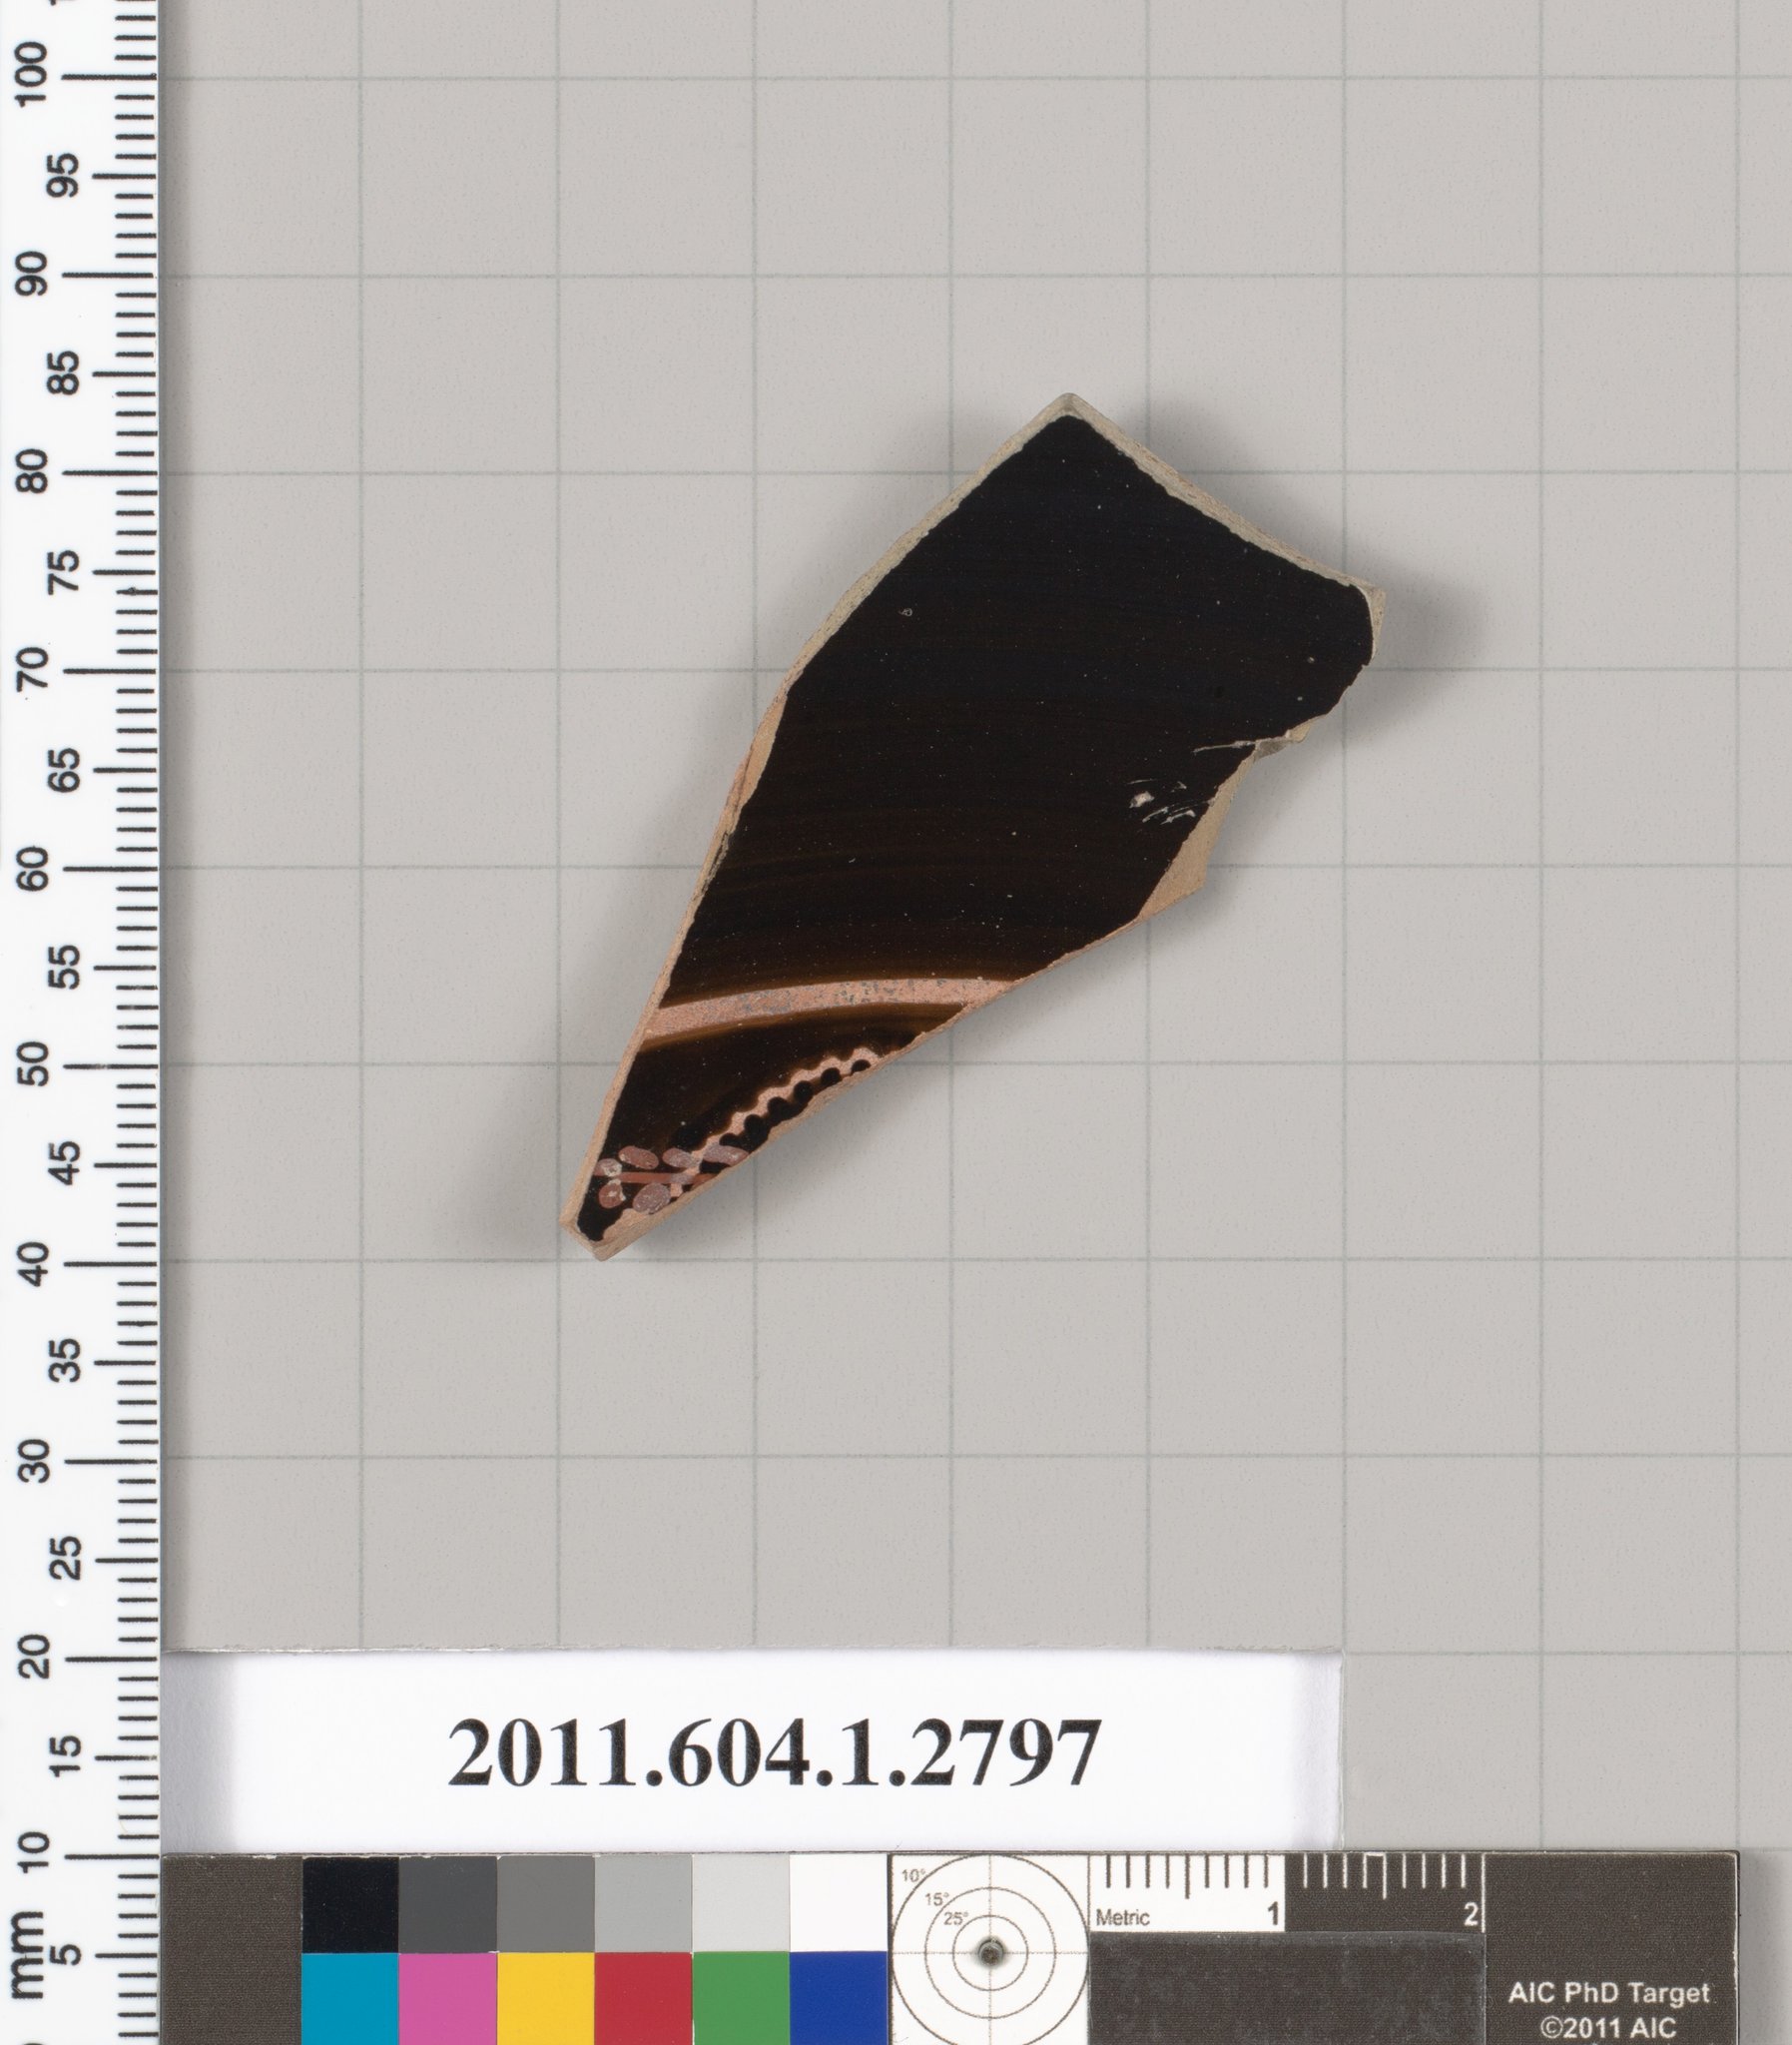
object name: kylix fragment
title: Terracotta fragment of a kylix (drinking cup)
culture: greek, attic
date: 520-500 BCE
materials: terracotta